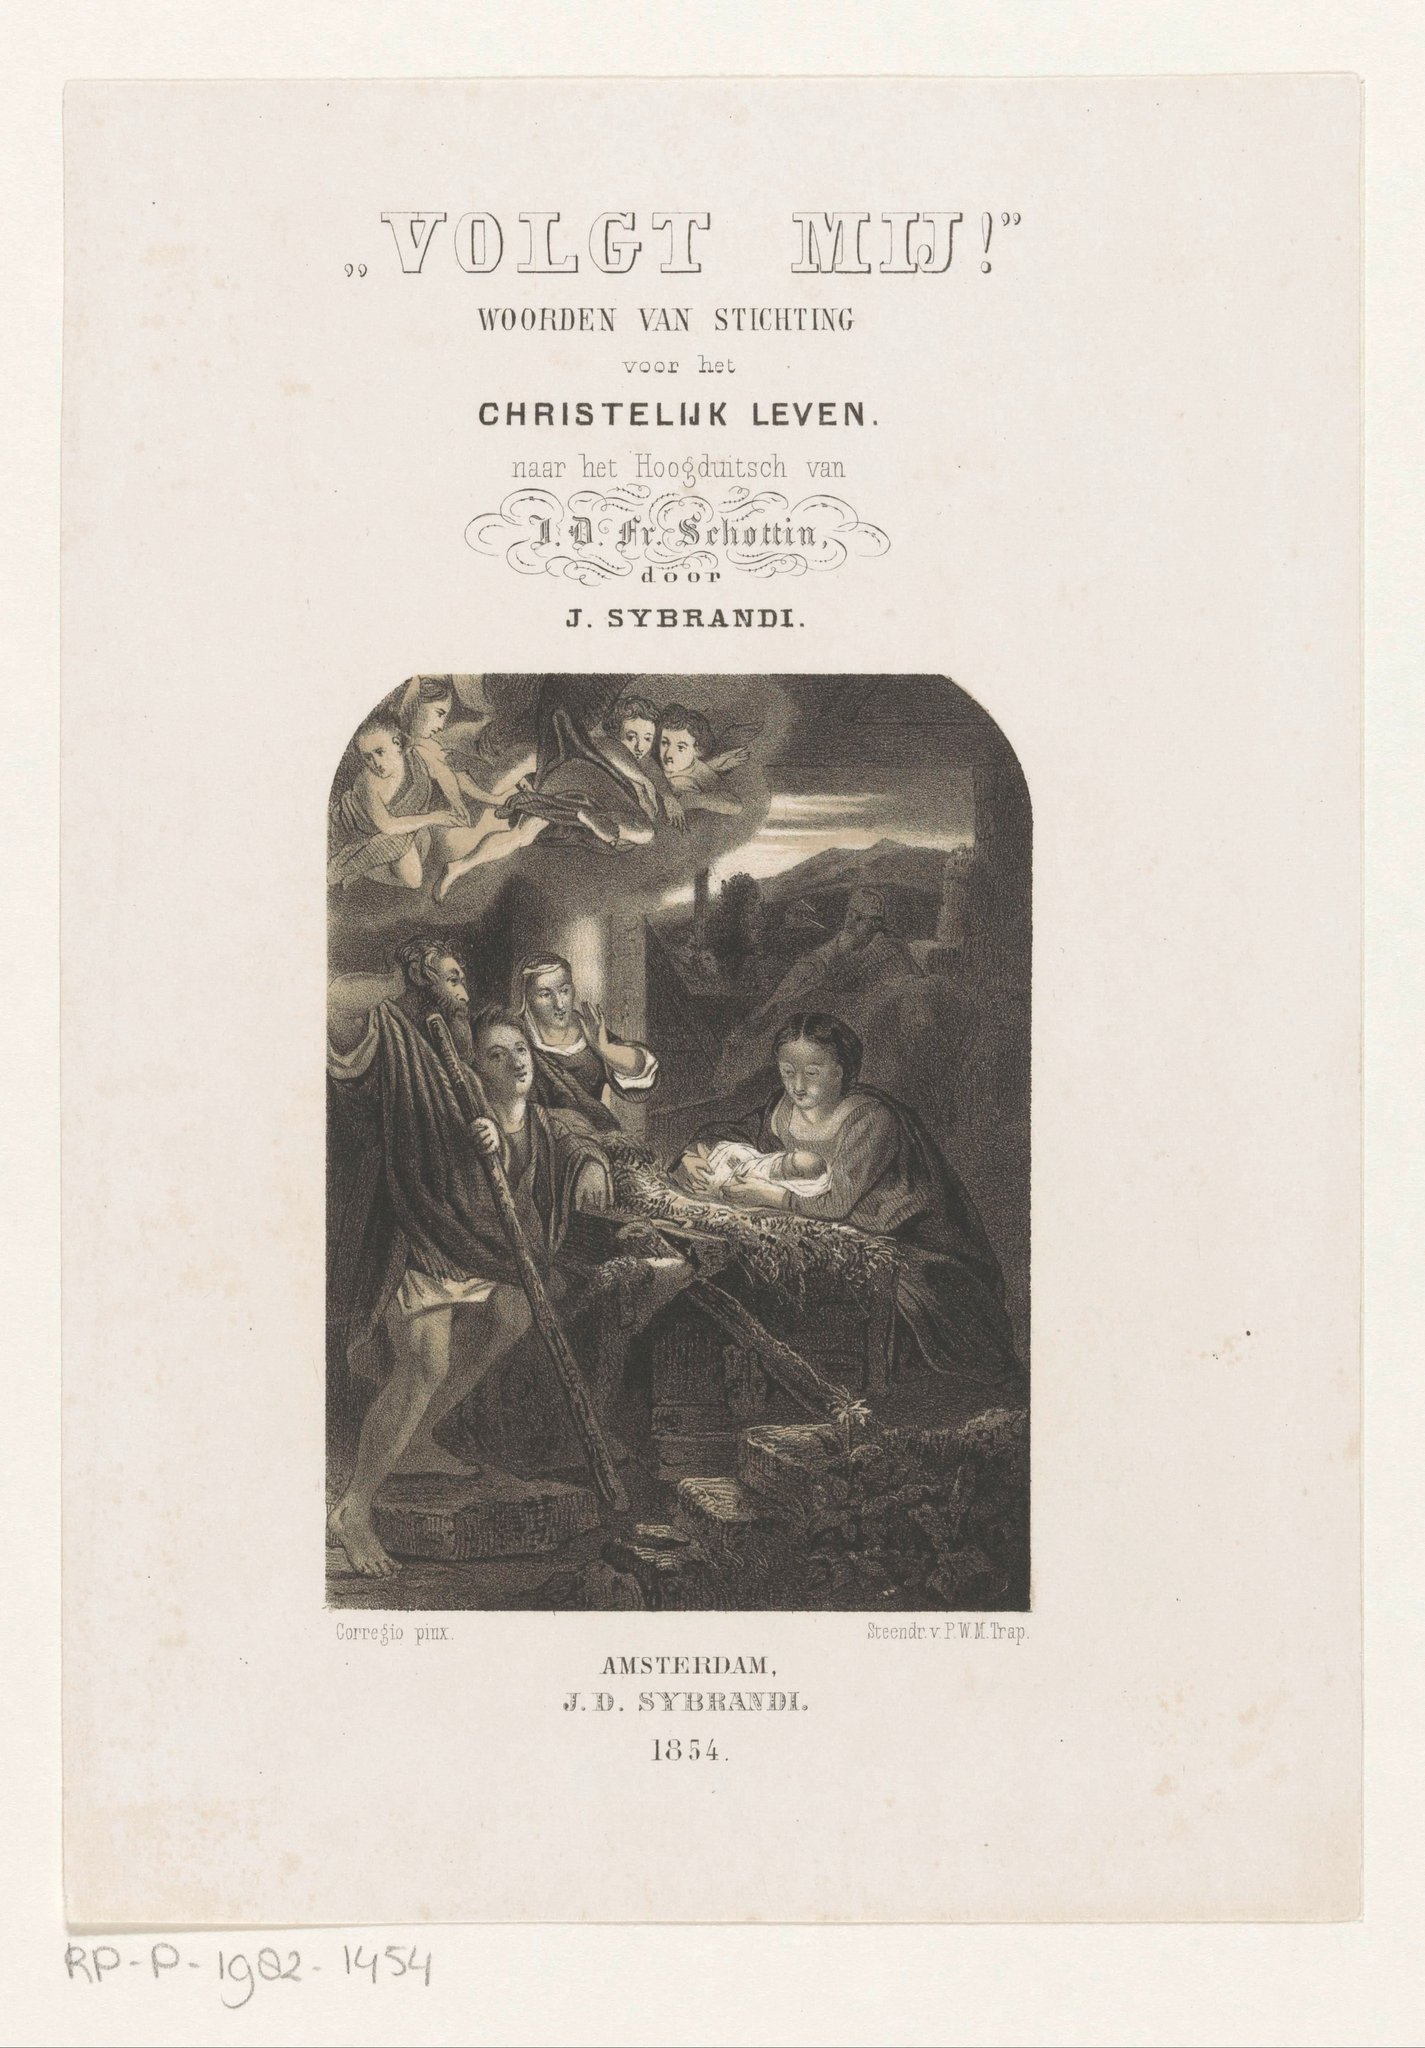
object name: print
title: Titelpagina voor: J. Sybrandi, Volgt mij! Woorden van stichting voor het christelijk leven, 1854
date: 1854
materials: paper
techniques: lithograph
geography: amsterdam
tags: adoration of the christ-child by the shepherds; mary and joseph present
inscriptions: collector's mark: Lugt 2228, collector's mark: Lugt 2760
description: Maria zit naast het Christuskind dat in een kribbe ligt. Links staan de drie herders. In de achtergrond Jozef bij de os en ezel. Boven het geheel een schare engelen.